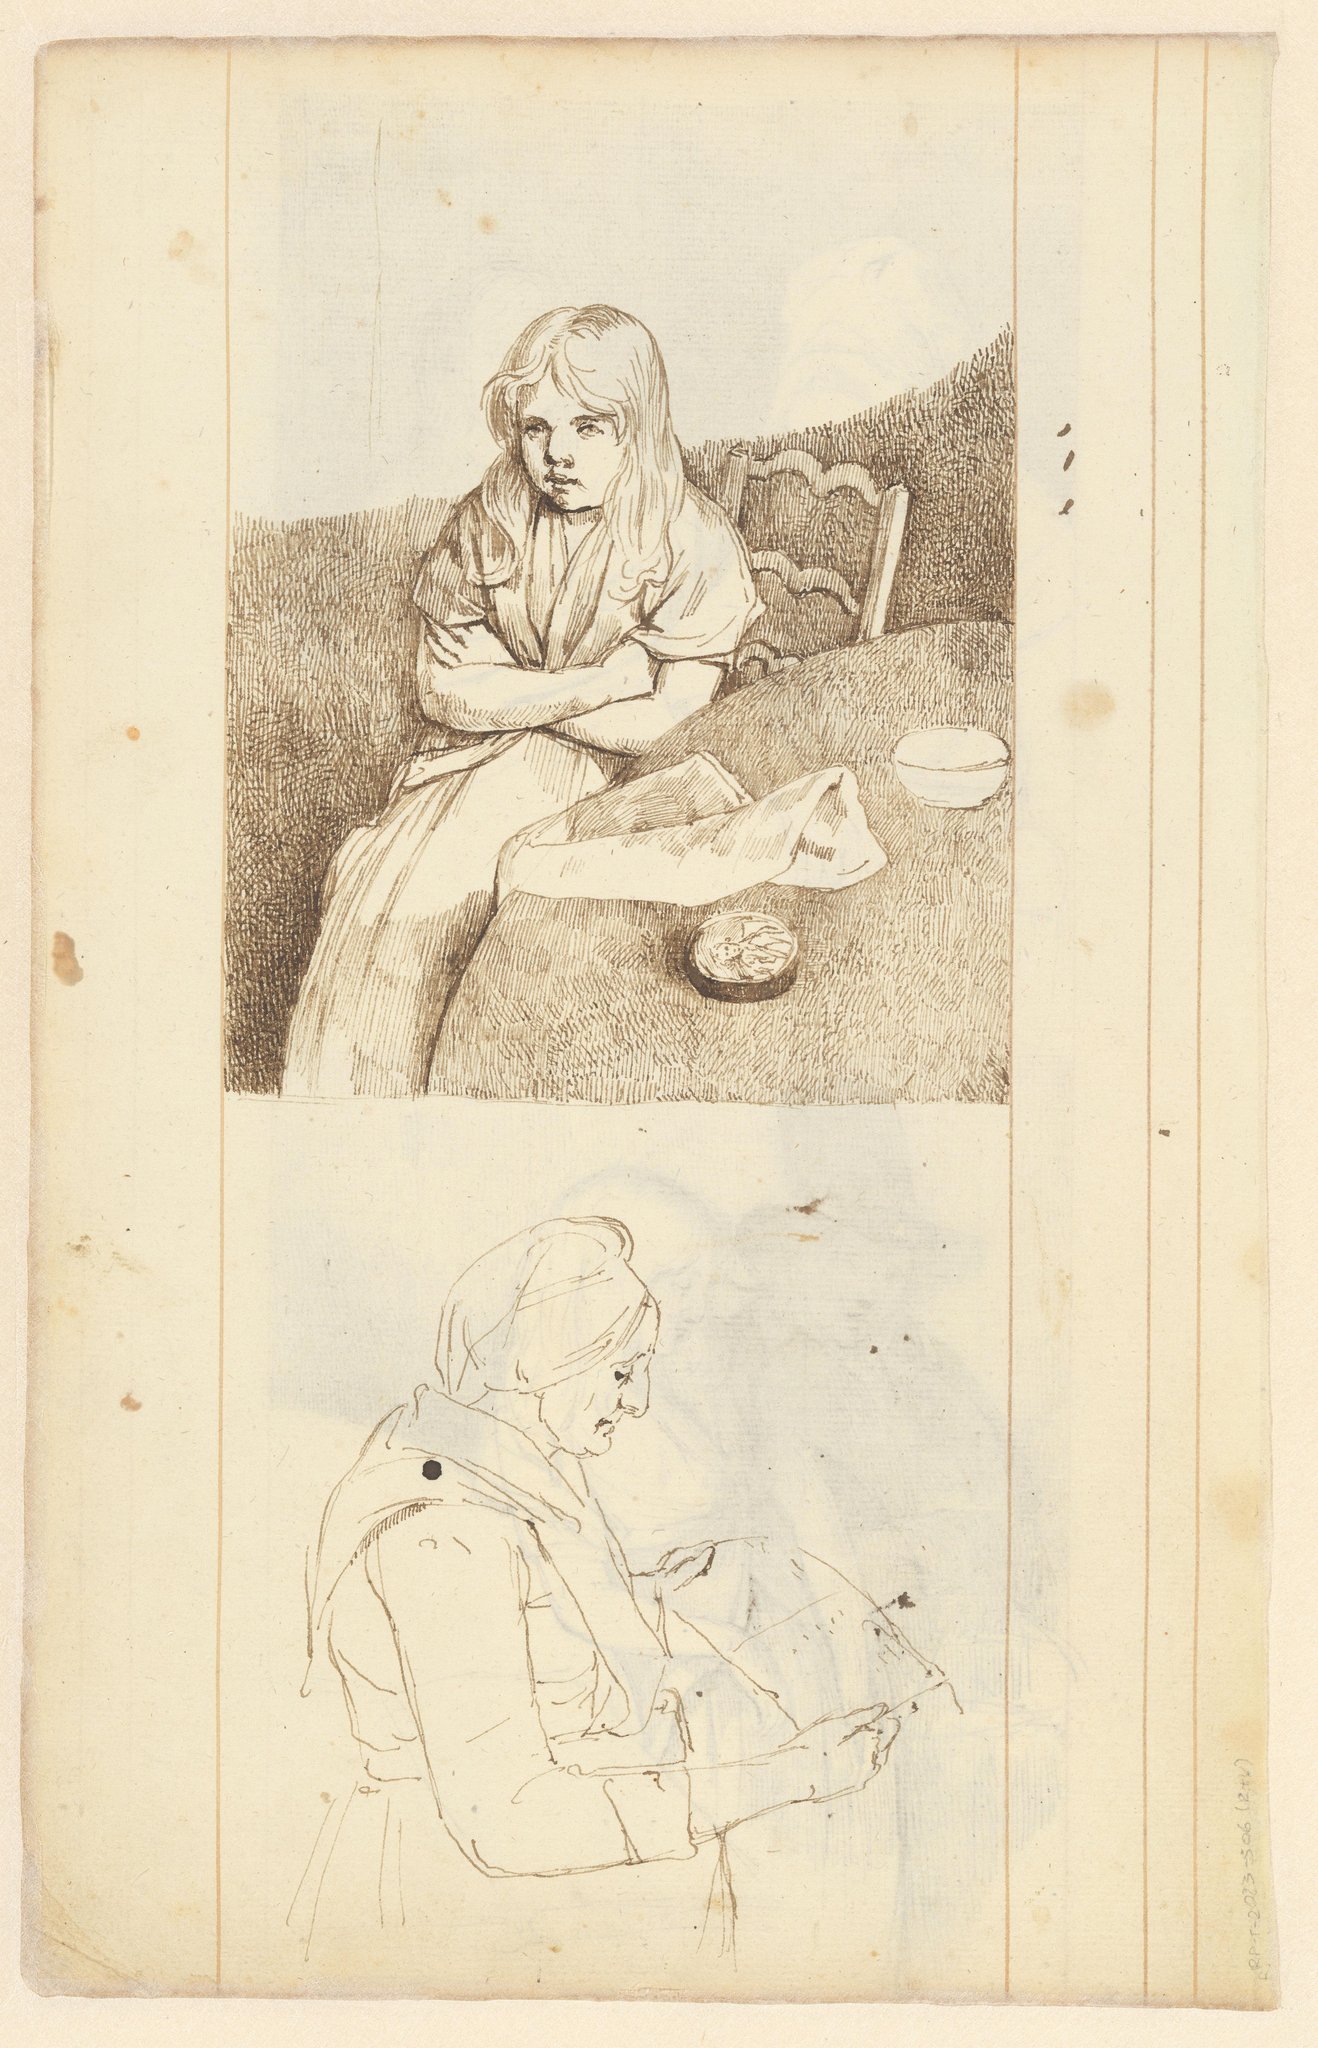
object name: drawing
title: Figuurstudies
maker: adélaïde-marie-anne moitte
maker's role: artist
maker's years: 1747-1807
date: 1797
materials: ink, paper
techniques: drawing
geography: paris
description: Twee studies: meisje aan tafel met medaillonportret en lezende vrouw.